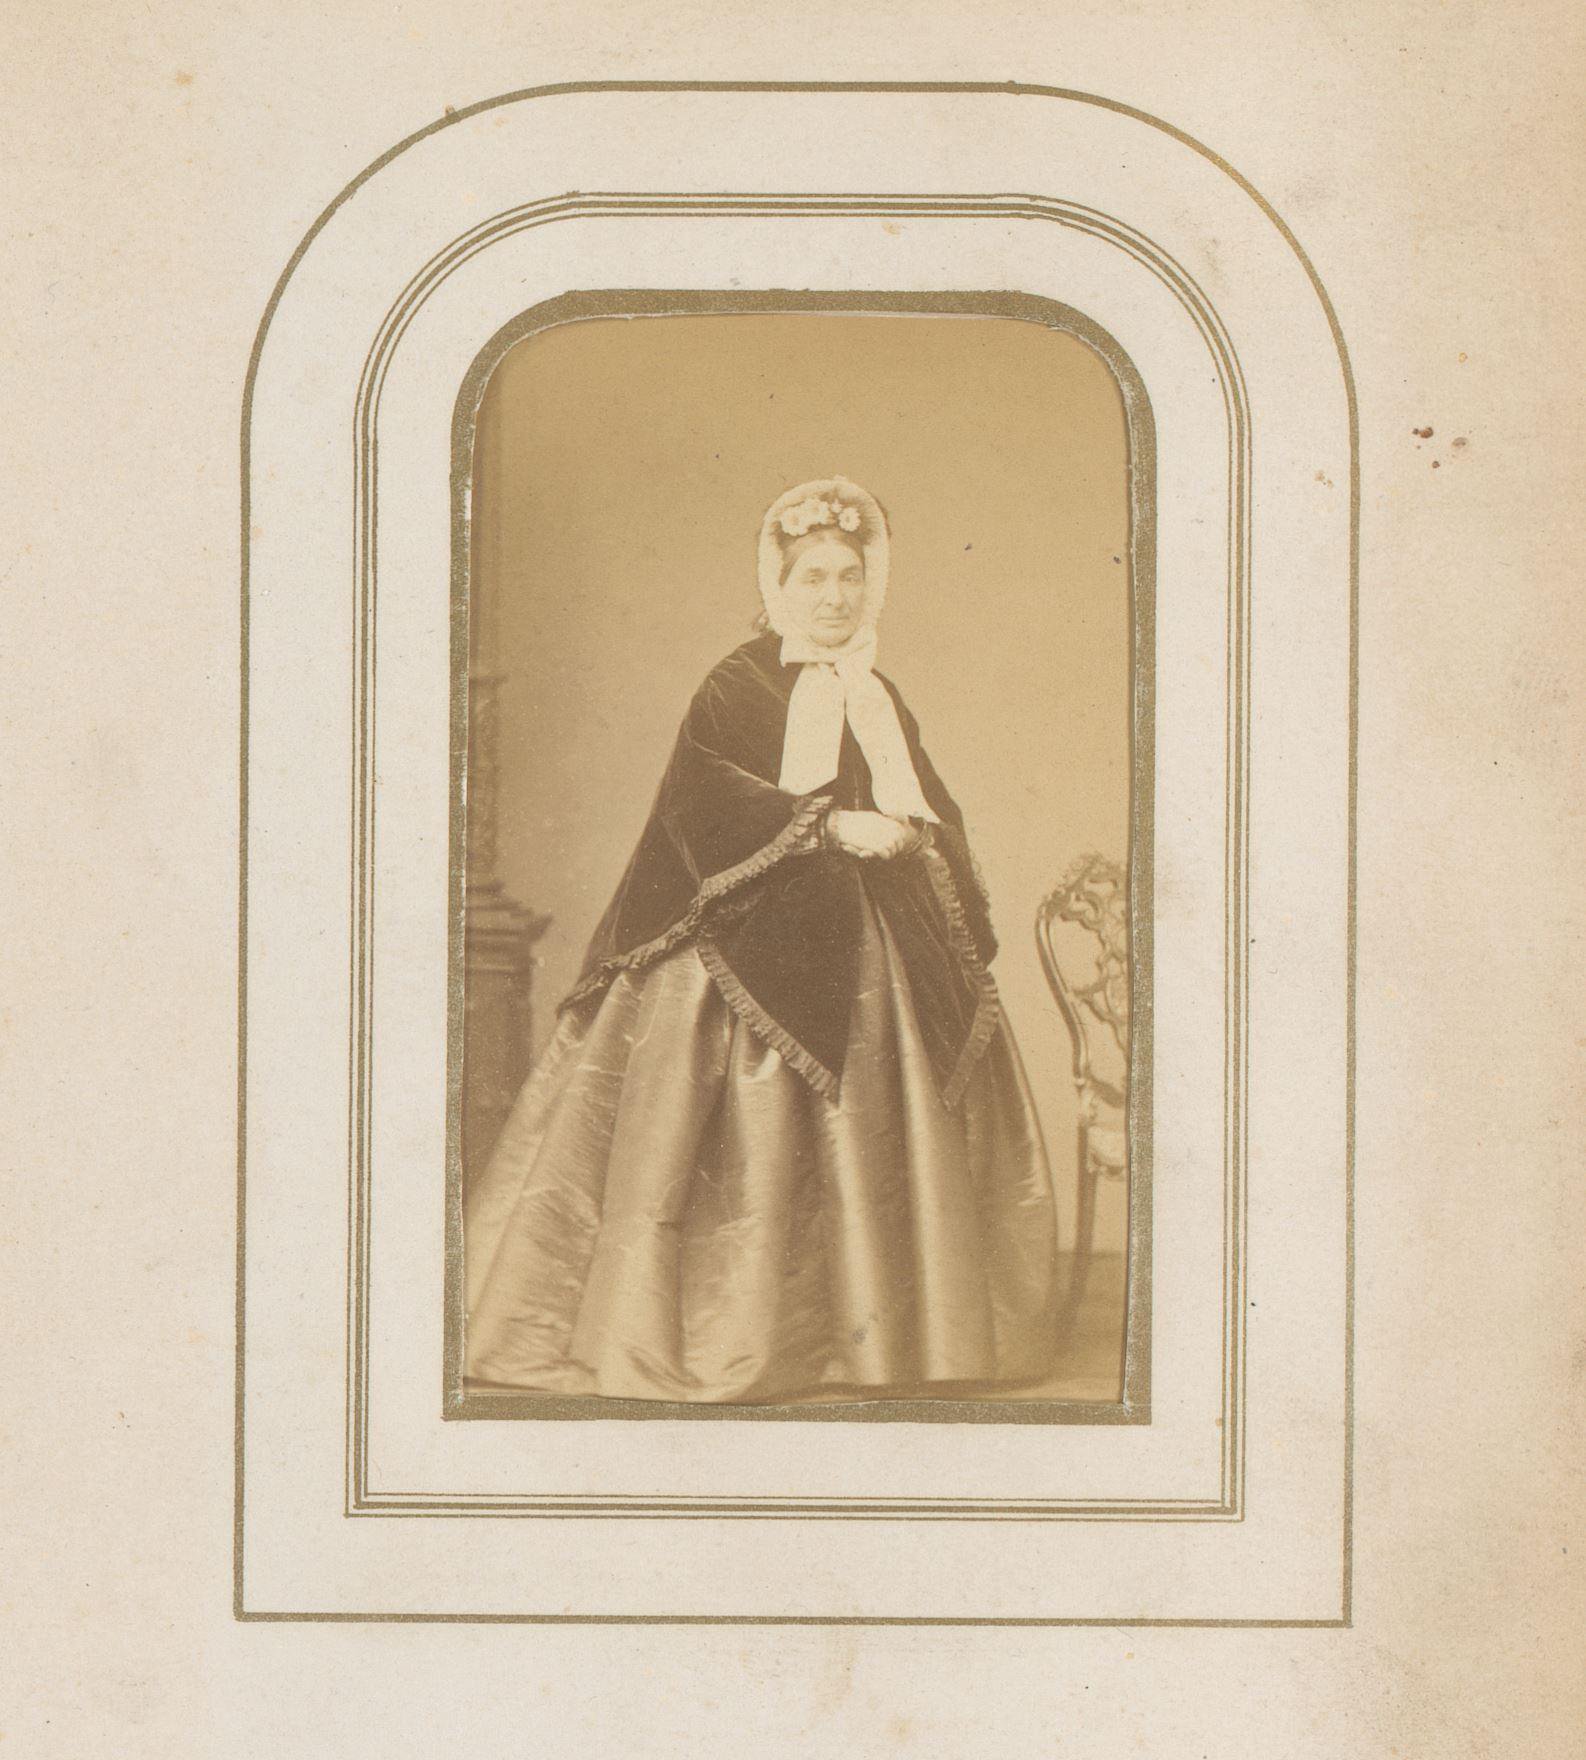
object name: photograph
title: Portret van een vrouw met muts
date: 1860-1880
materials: cardboard, photographic support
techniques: albumen print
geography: brussels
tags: historical persons - bb - woman, head-gear: hat, standing figure - aa - female human figure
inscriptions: inscription: ‘Establissement Photographiqué/ de Maes & Michaux/ Place de la Monnaie/ 36, Rue Fossé-aux-Loups/ Bruxelles’